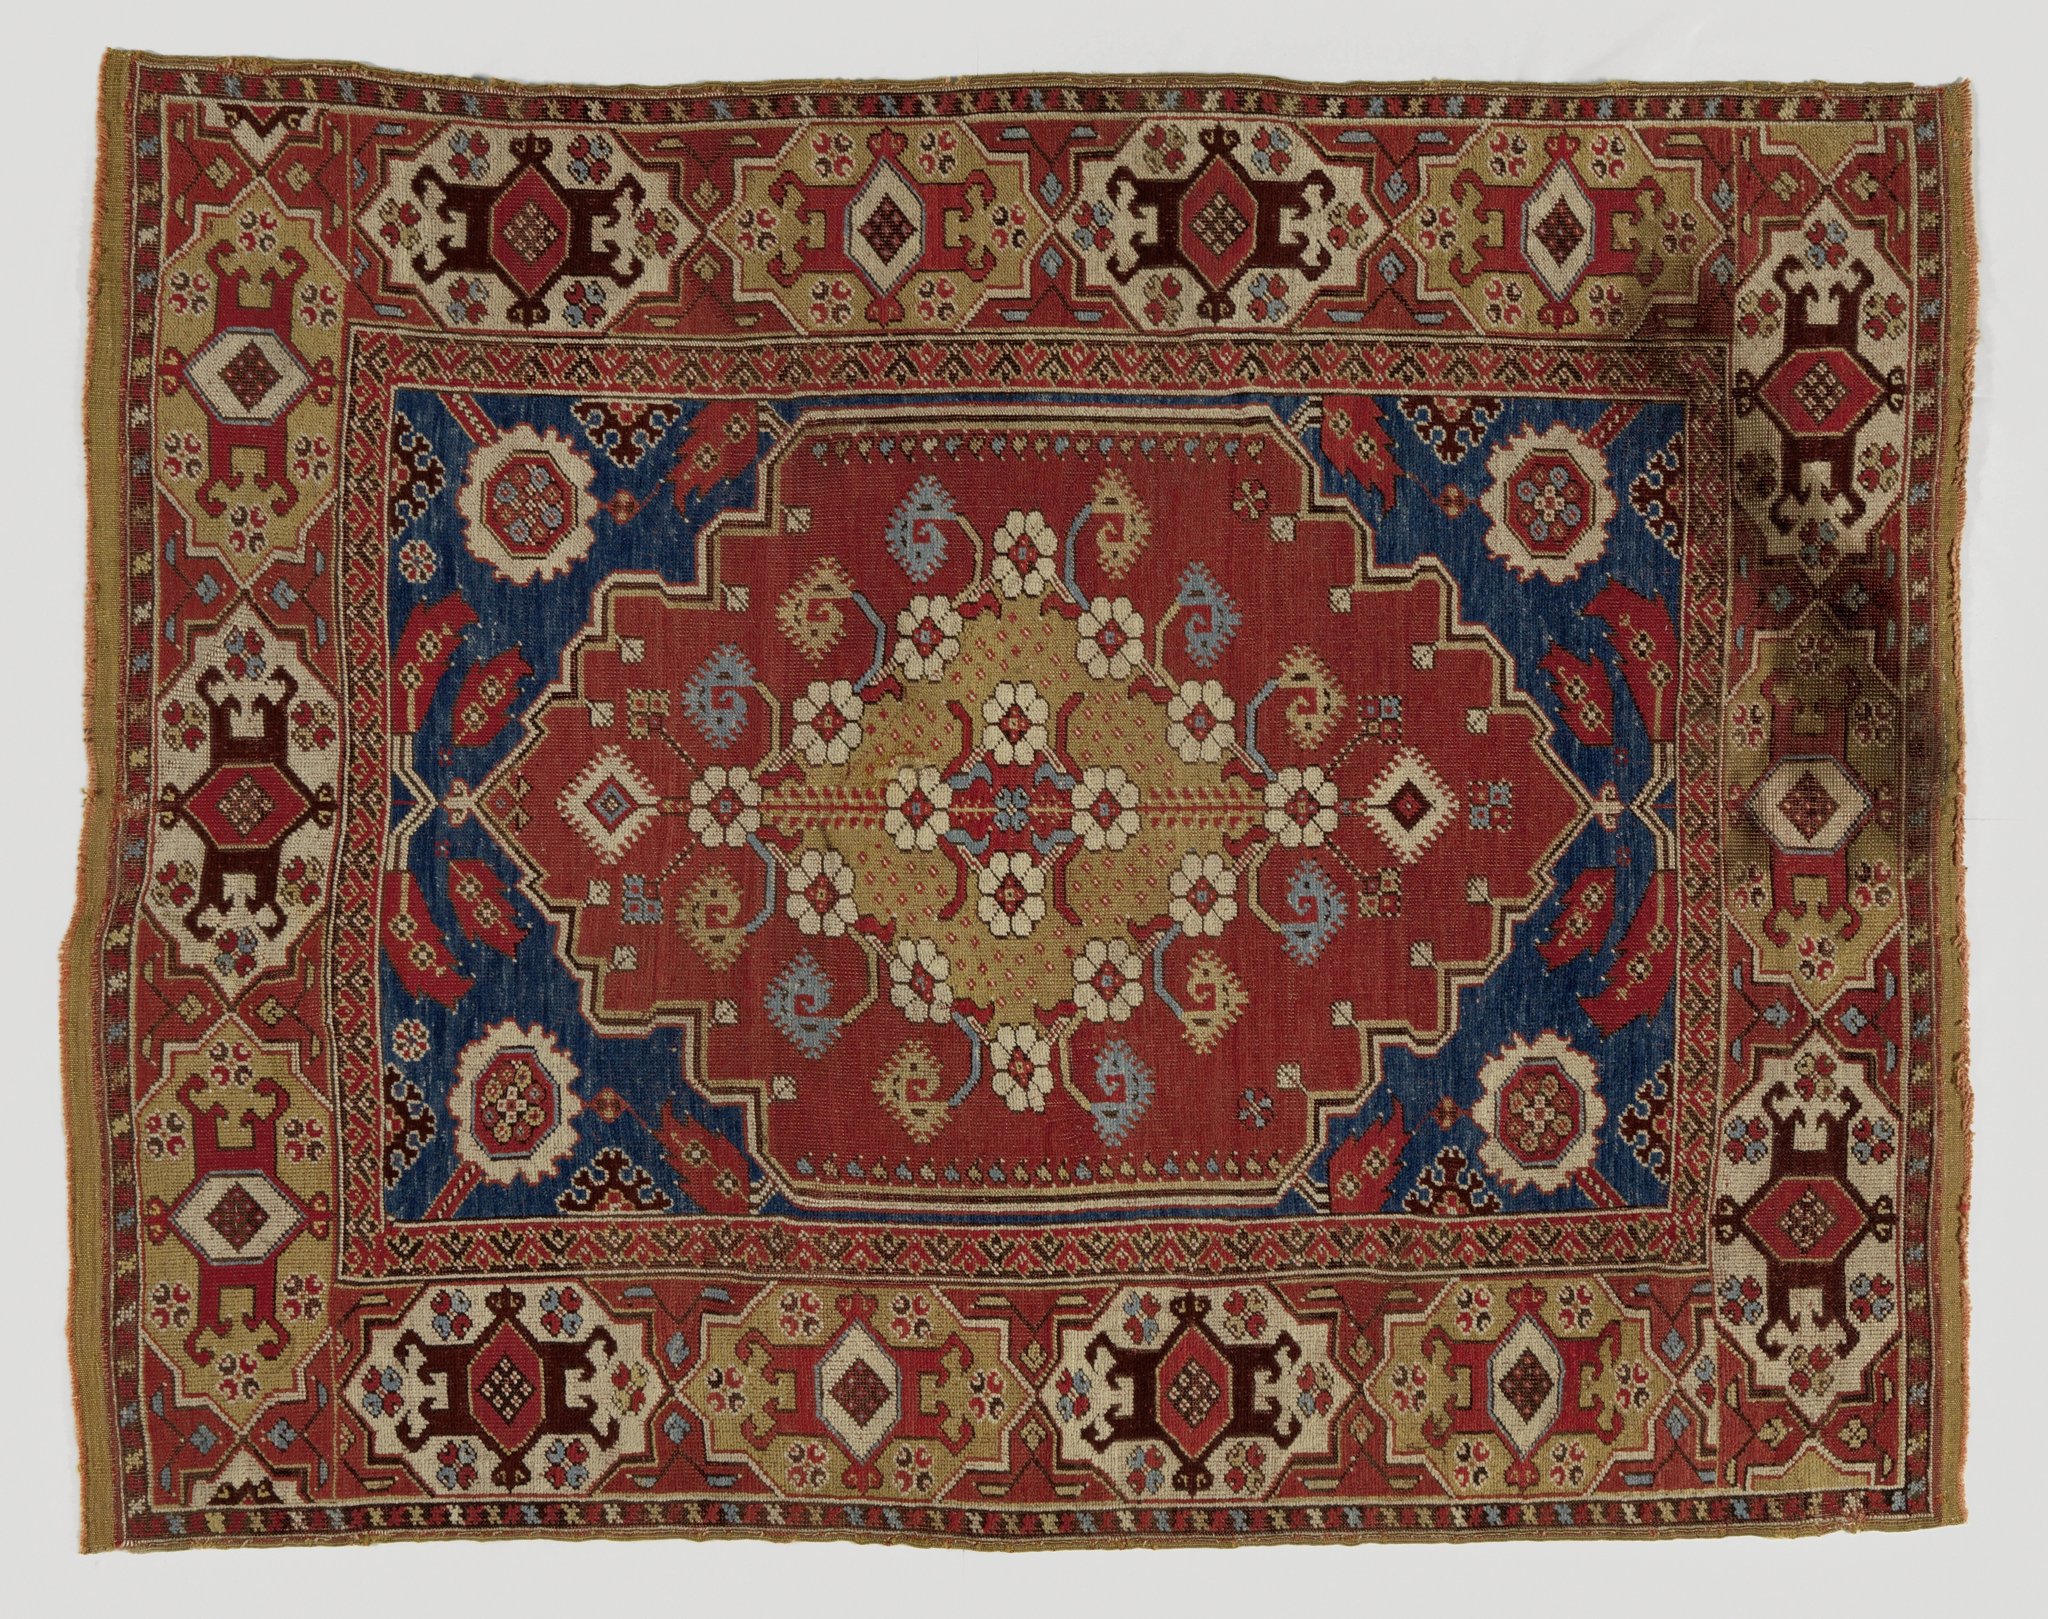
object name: oriental rug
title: Bidkleed, z.g. ZEVENBURGEN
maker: Anonymous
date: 1650-1670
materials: wool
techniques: ghiordes knot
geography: asia minor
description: Bidkleed, z.g. Zevenburgen. Middenveld: steenrode dubbele mihrab met in ruitvormen geschikte witte rozetbloem op een okergele middenruit en een concentrische rode ruit. Op korenblauwe zwikken staan telkens één witte rozetbloem en rode zaagtandbladeren. Rand: drievoudig. De hoofdrand is steenrood met gelijke aaneengeschakelde cartouches in wit en zachtgeel, waarvan de vulling een H-motief is, afgeleid van een paar arabesken, resp. in paarsbruin en steenrood. De binnenzoom van reciproque V-bladeren in rood en paarsbruin; de buitenzoom is paarsbruin met een bladrank. Beide zomen zijn gevat in een effen bies.